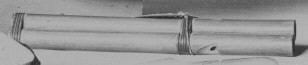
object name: wind instrument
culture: japanese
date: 1801-1900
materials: wood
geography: japan